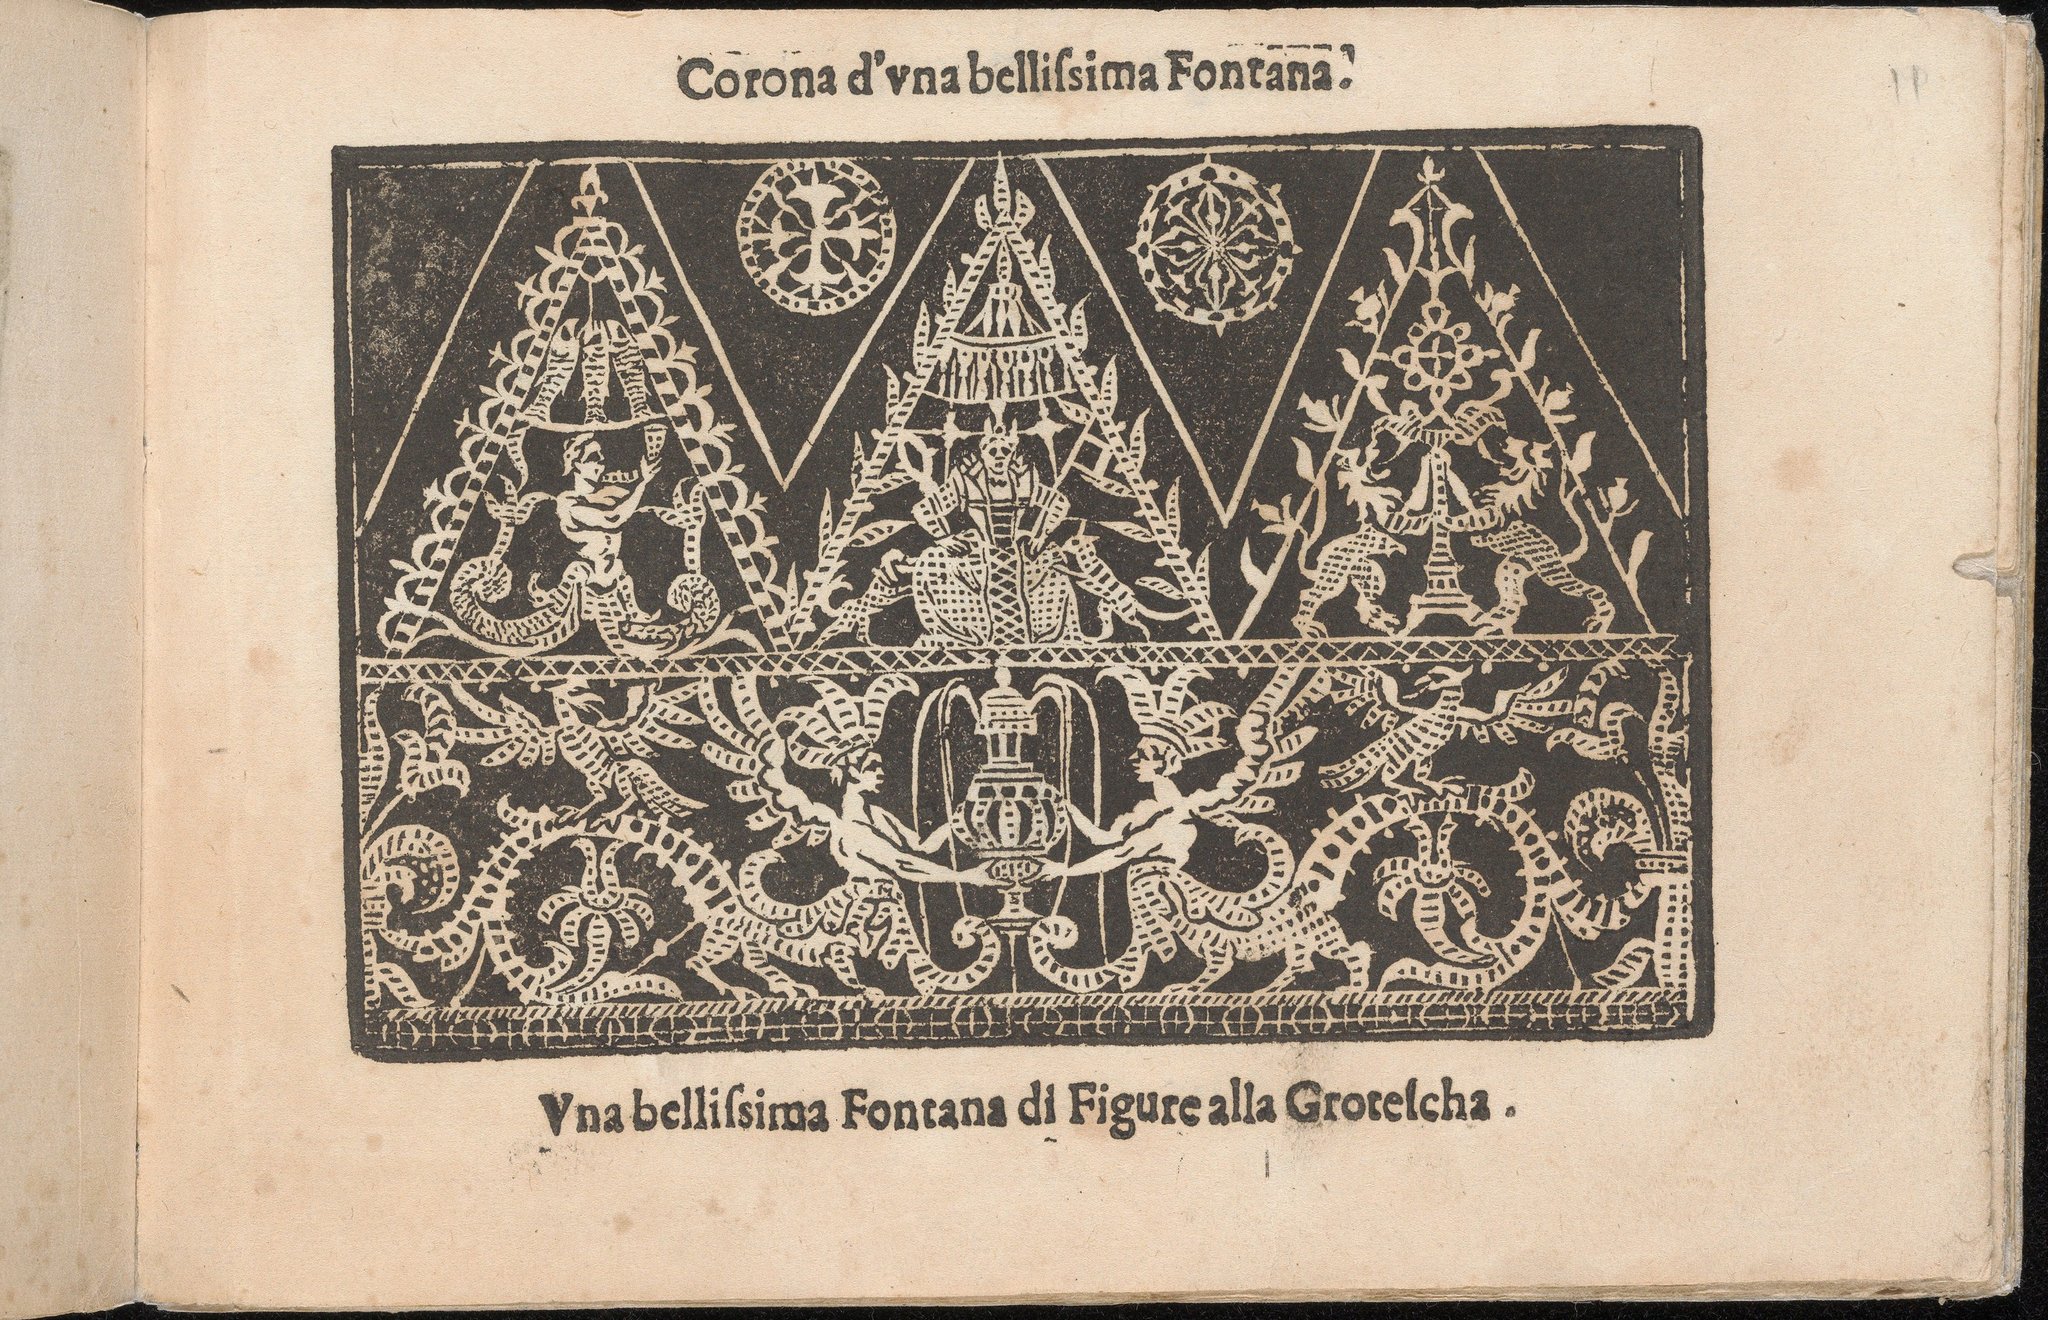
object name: book print ornament architecture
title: Corona delle Nobile et Virtuose Donne, Libro Terzo, page 11 (recto)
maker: cesare vecellio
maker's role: designer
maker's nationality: italian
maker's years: 1521-1601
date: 1620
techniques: woodcut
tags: birds,ornament,mythical creatures